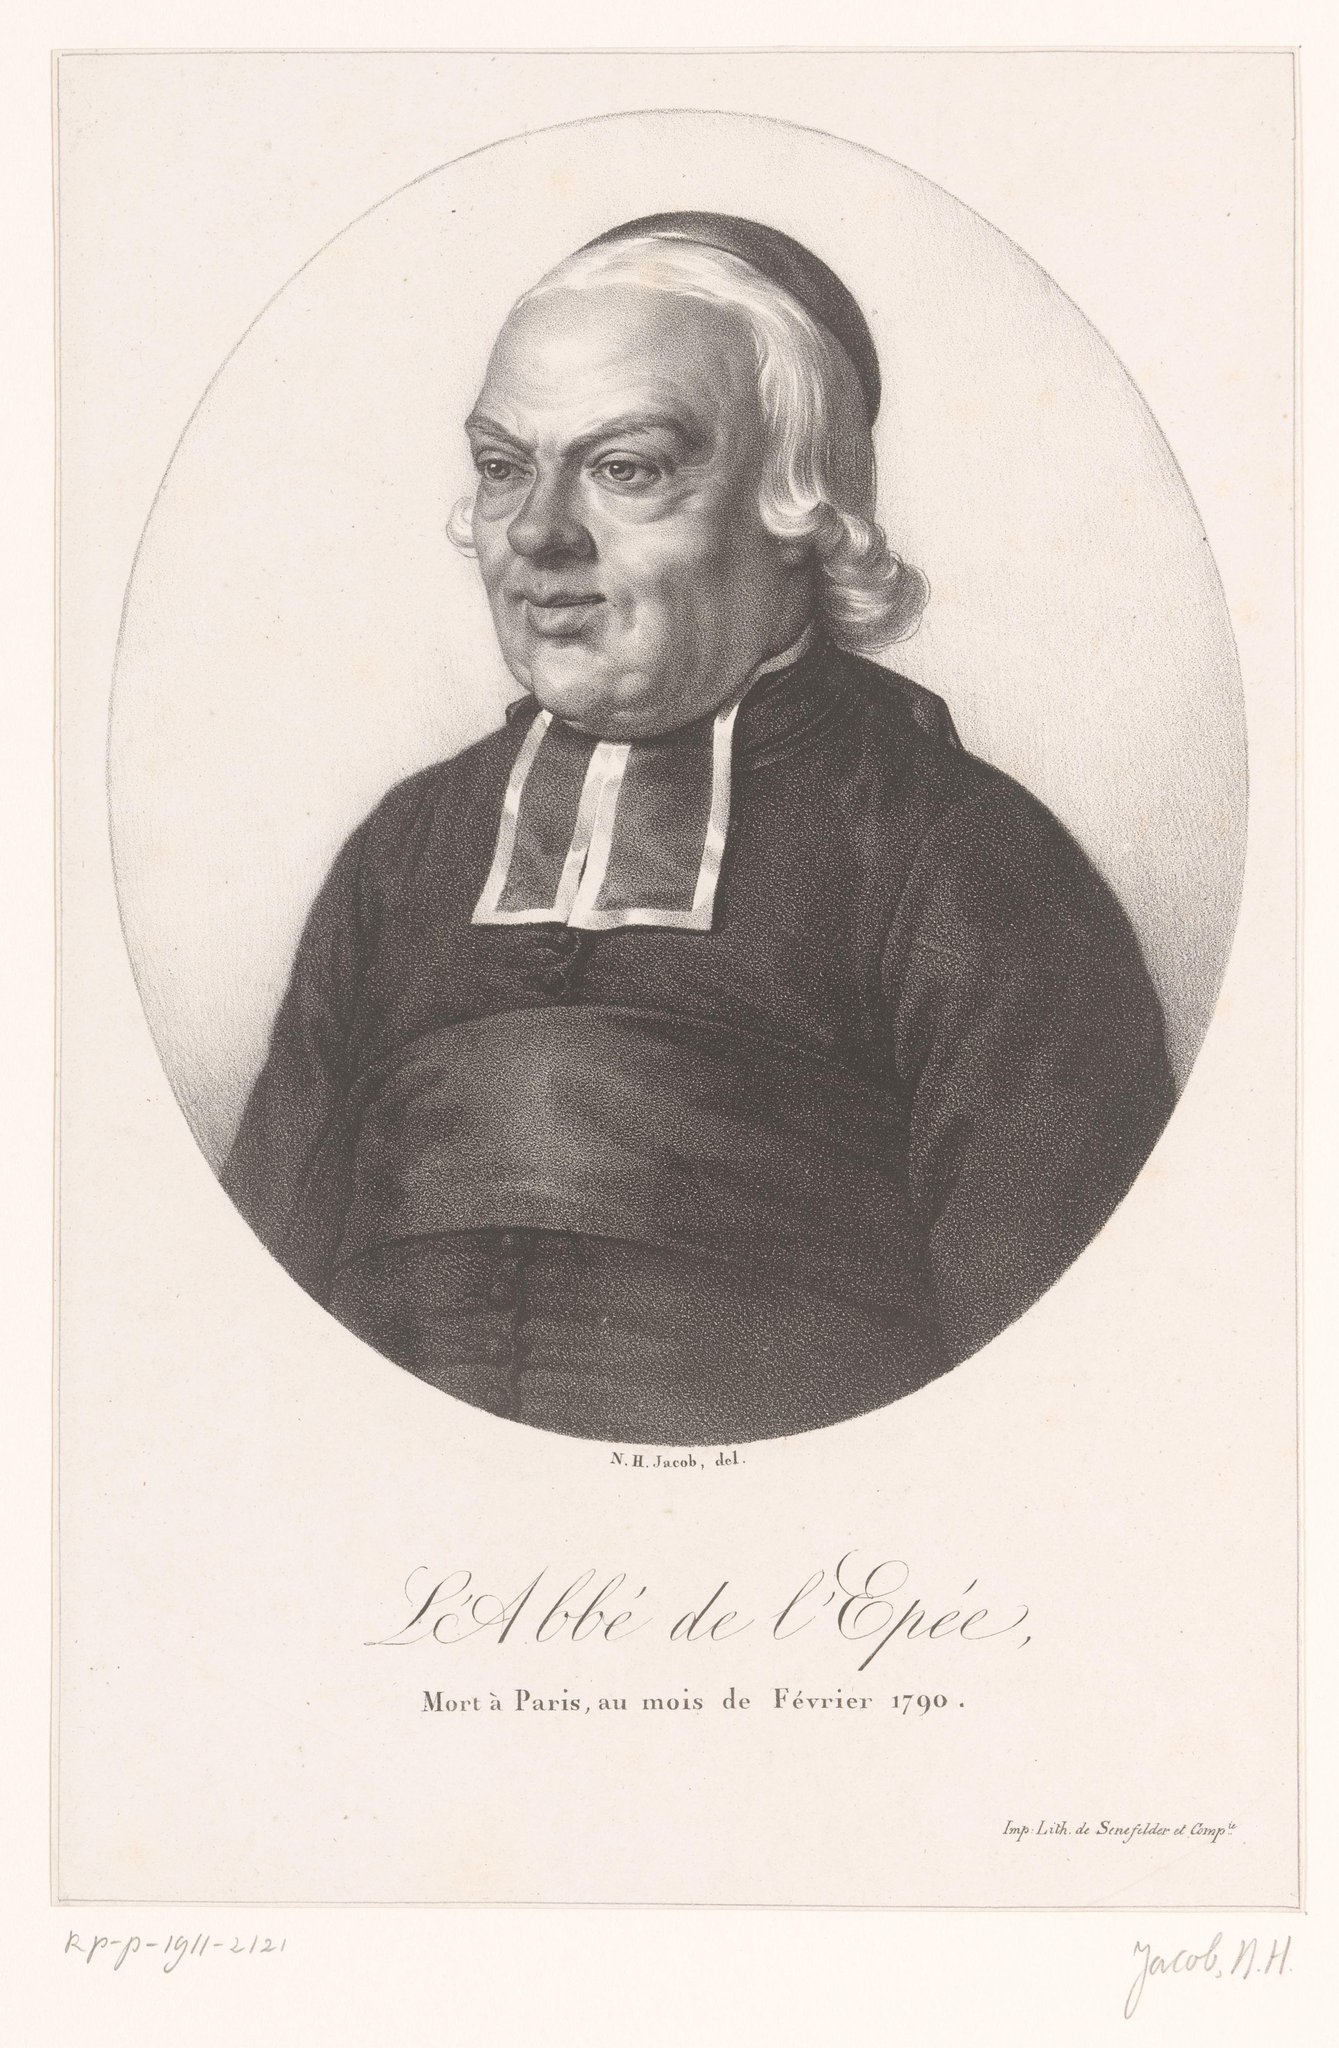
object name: book illustration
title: Portret van Charles-Michel de L'Épée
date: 1825-1827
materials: paper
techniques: lithograph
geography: paris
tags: paris, historical persons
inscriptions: collector's mark: Lugt 2228a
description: Prent gebruikt voor: Le Panthéon français, ou Collection de portraits des personnages célèbres (...). Parijs: P. Sudré, 1825-1827.